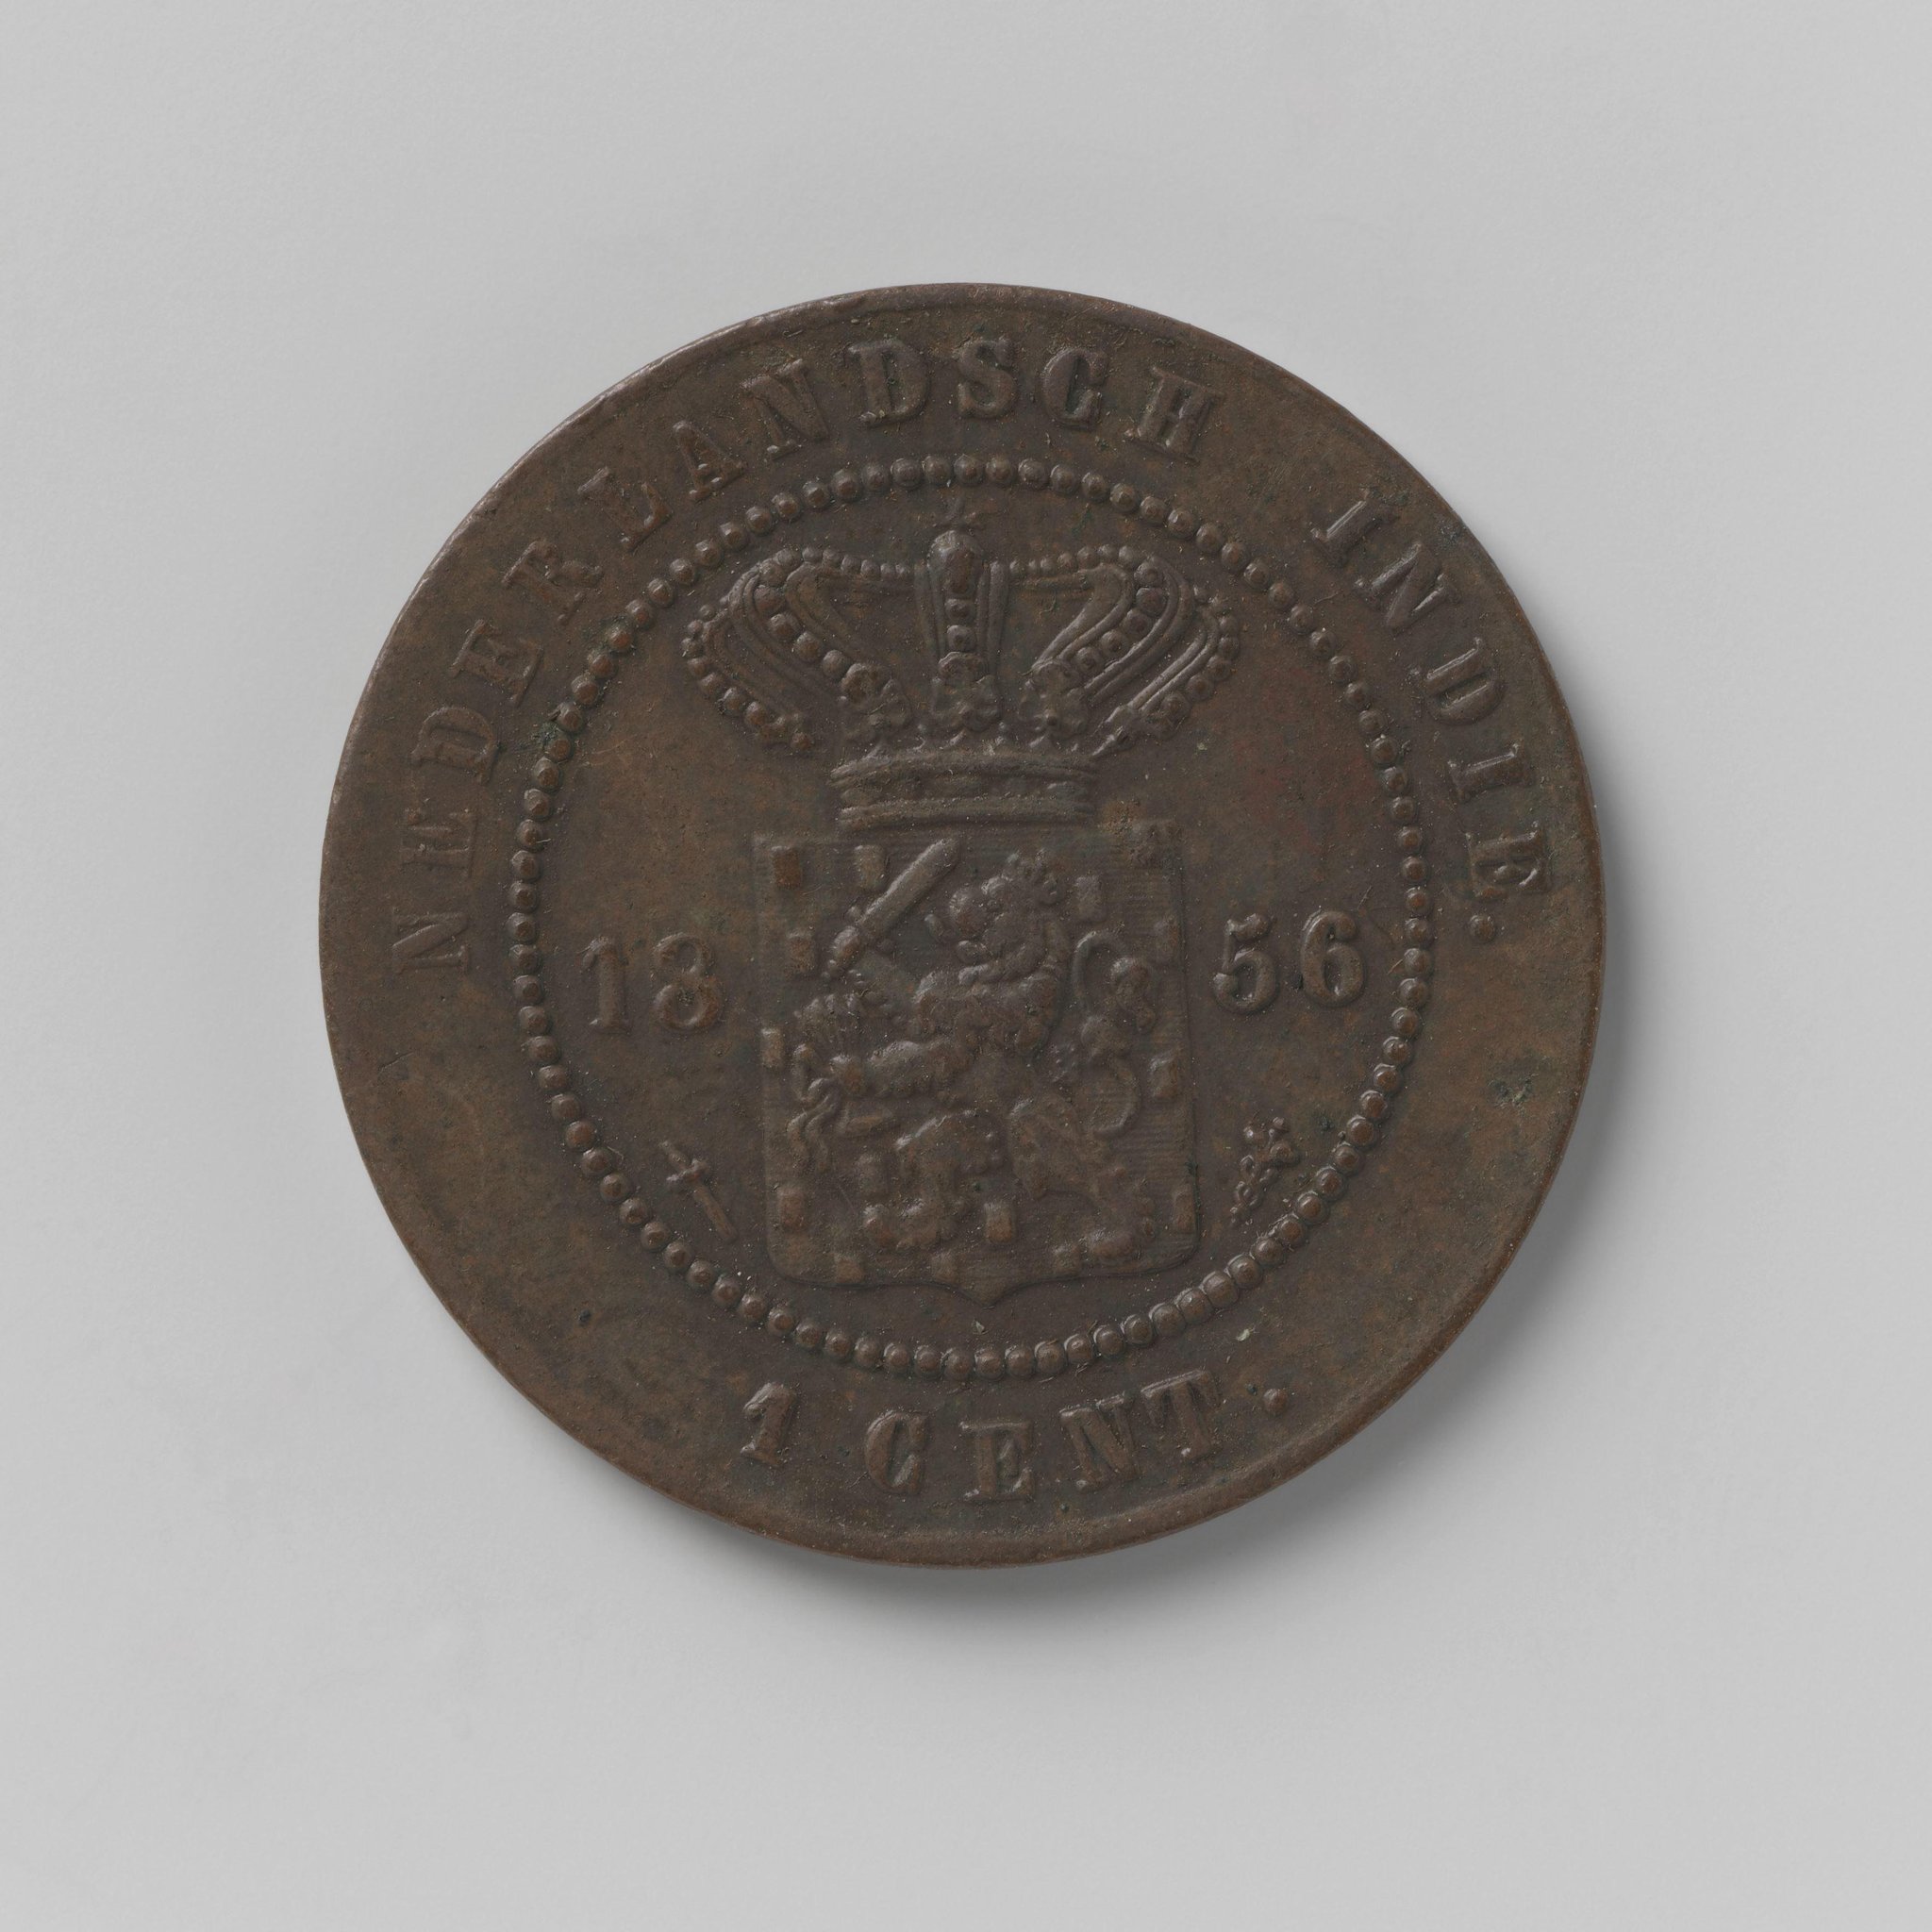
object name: coin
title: Cent van Nederlands Indië,1856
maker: willem iii (koning der nederlanden)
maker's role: koning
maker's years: 1817-1890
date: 1856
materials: copper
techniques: striking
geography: utrecht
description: Koperen munt. Voorzijde: tussen jaartal gekroond rijkswapenschild. Boven kroon landsaanduiding en onder wapenschild waarde-aanduiding. Keerzijde: tweeregelig Maleis opschrift in Arabische tekens, waaromheen omschrift in het Javaans. Gladde rand.